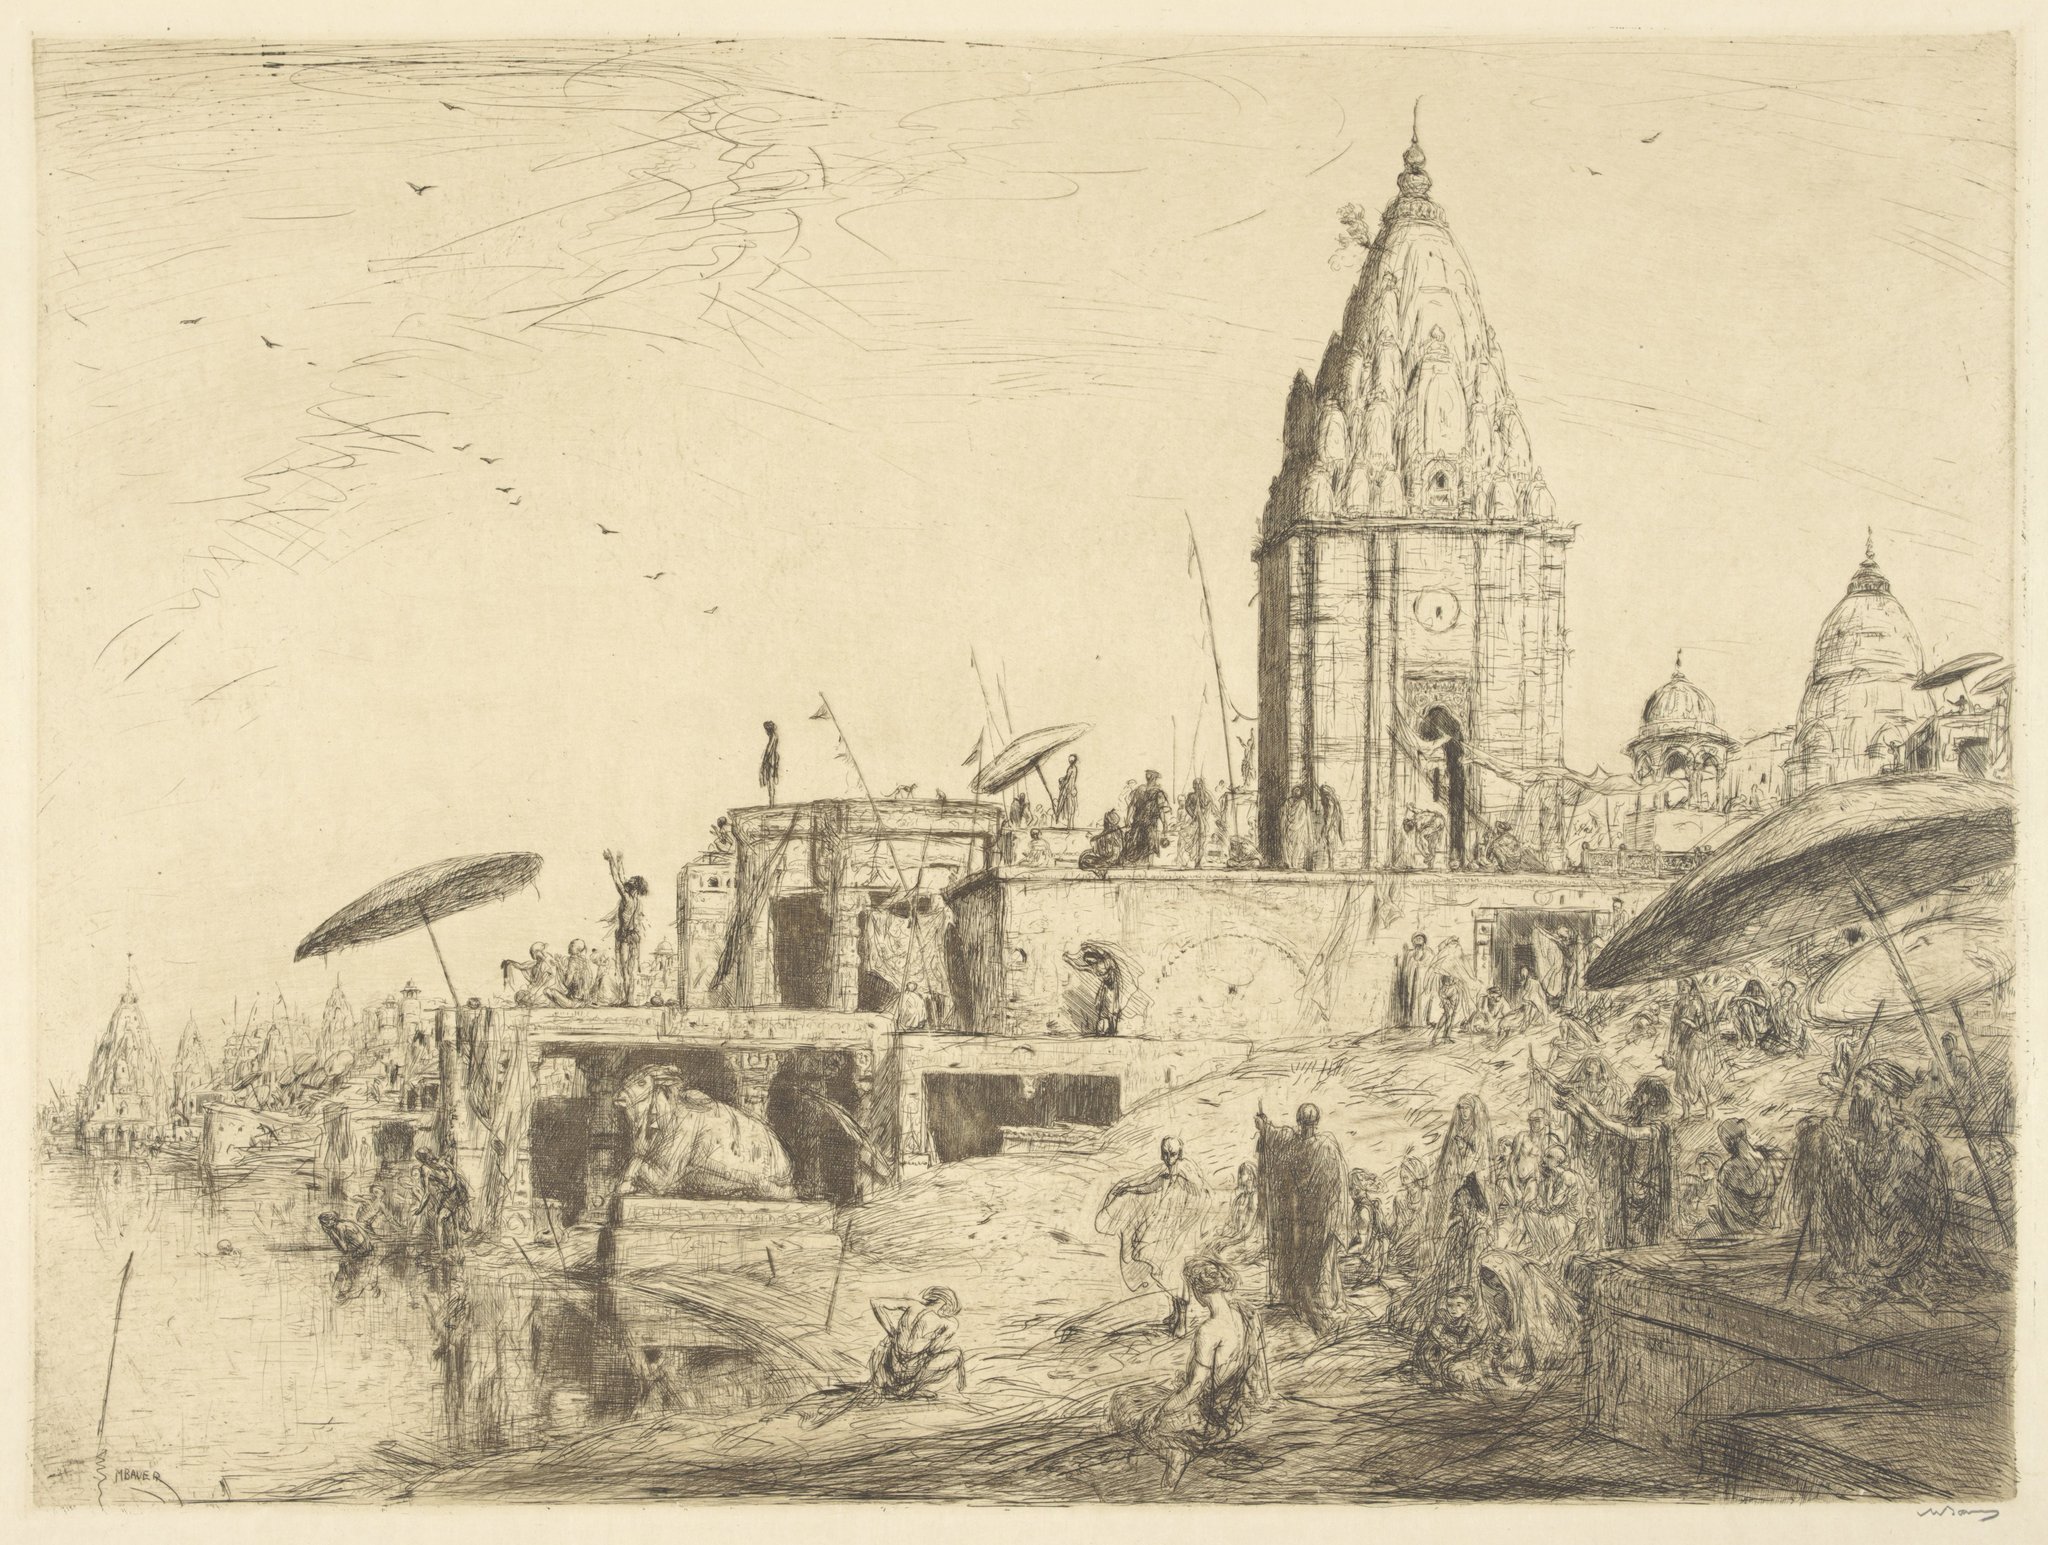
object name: print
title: Badende Hindoes aan de oever van de Ganges in Varanasi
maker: marius bauer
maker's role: draughtsman, print maker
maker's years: 1867-1932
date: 1919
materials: paper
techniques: etching, intaglio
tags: places and objects of worship ~ hinduism, buddhism, jainism, river, public baths - aa - in the open air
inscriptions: collector's mark: Lugt 2228